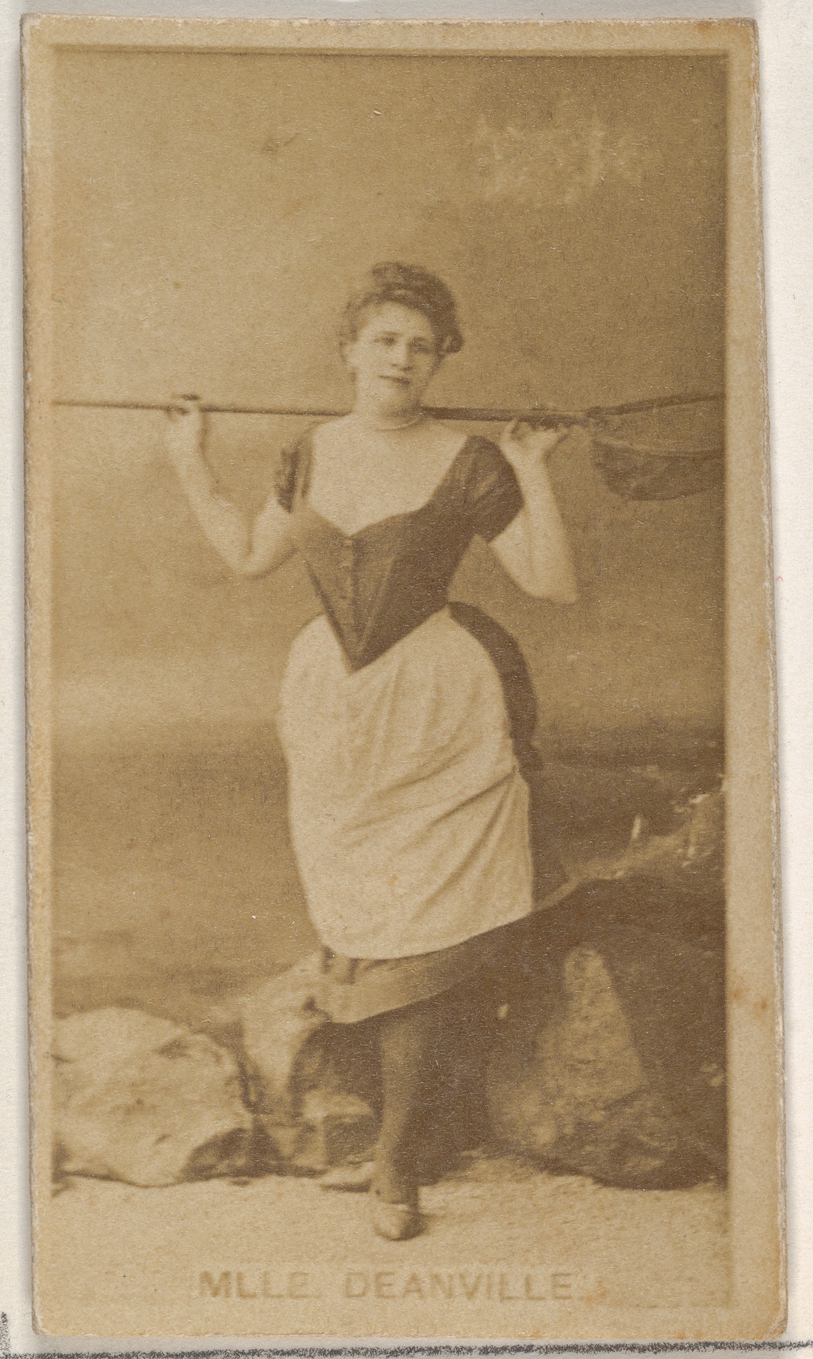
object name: photograph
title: Mlle. Deanville, from the Actors and Actresses series (N45, Type 8) for Virginia Brights Cigarettes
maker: allen & ginter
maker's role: publisher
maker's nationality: american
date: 1888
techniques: albumen silver print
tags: portraits,women,actresses